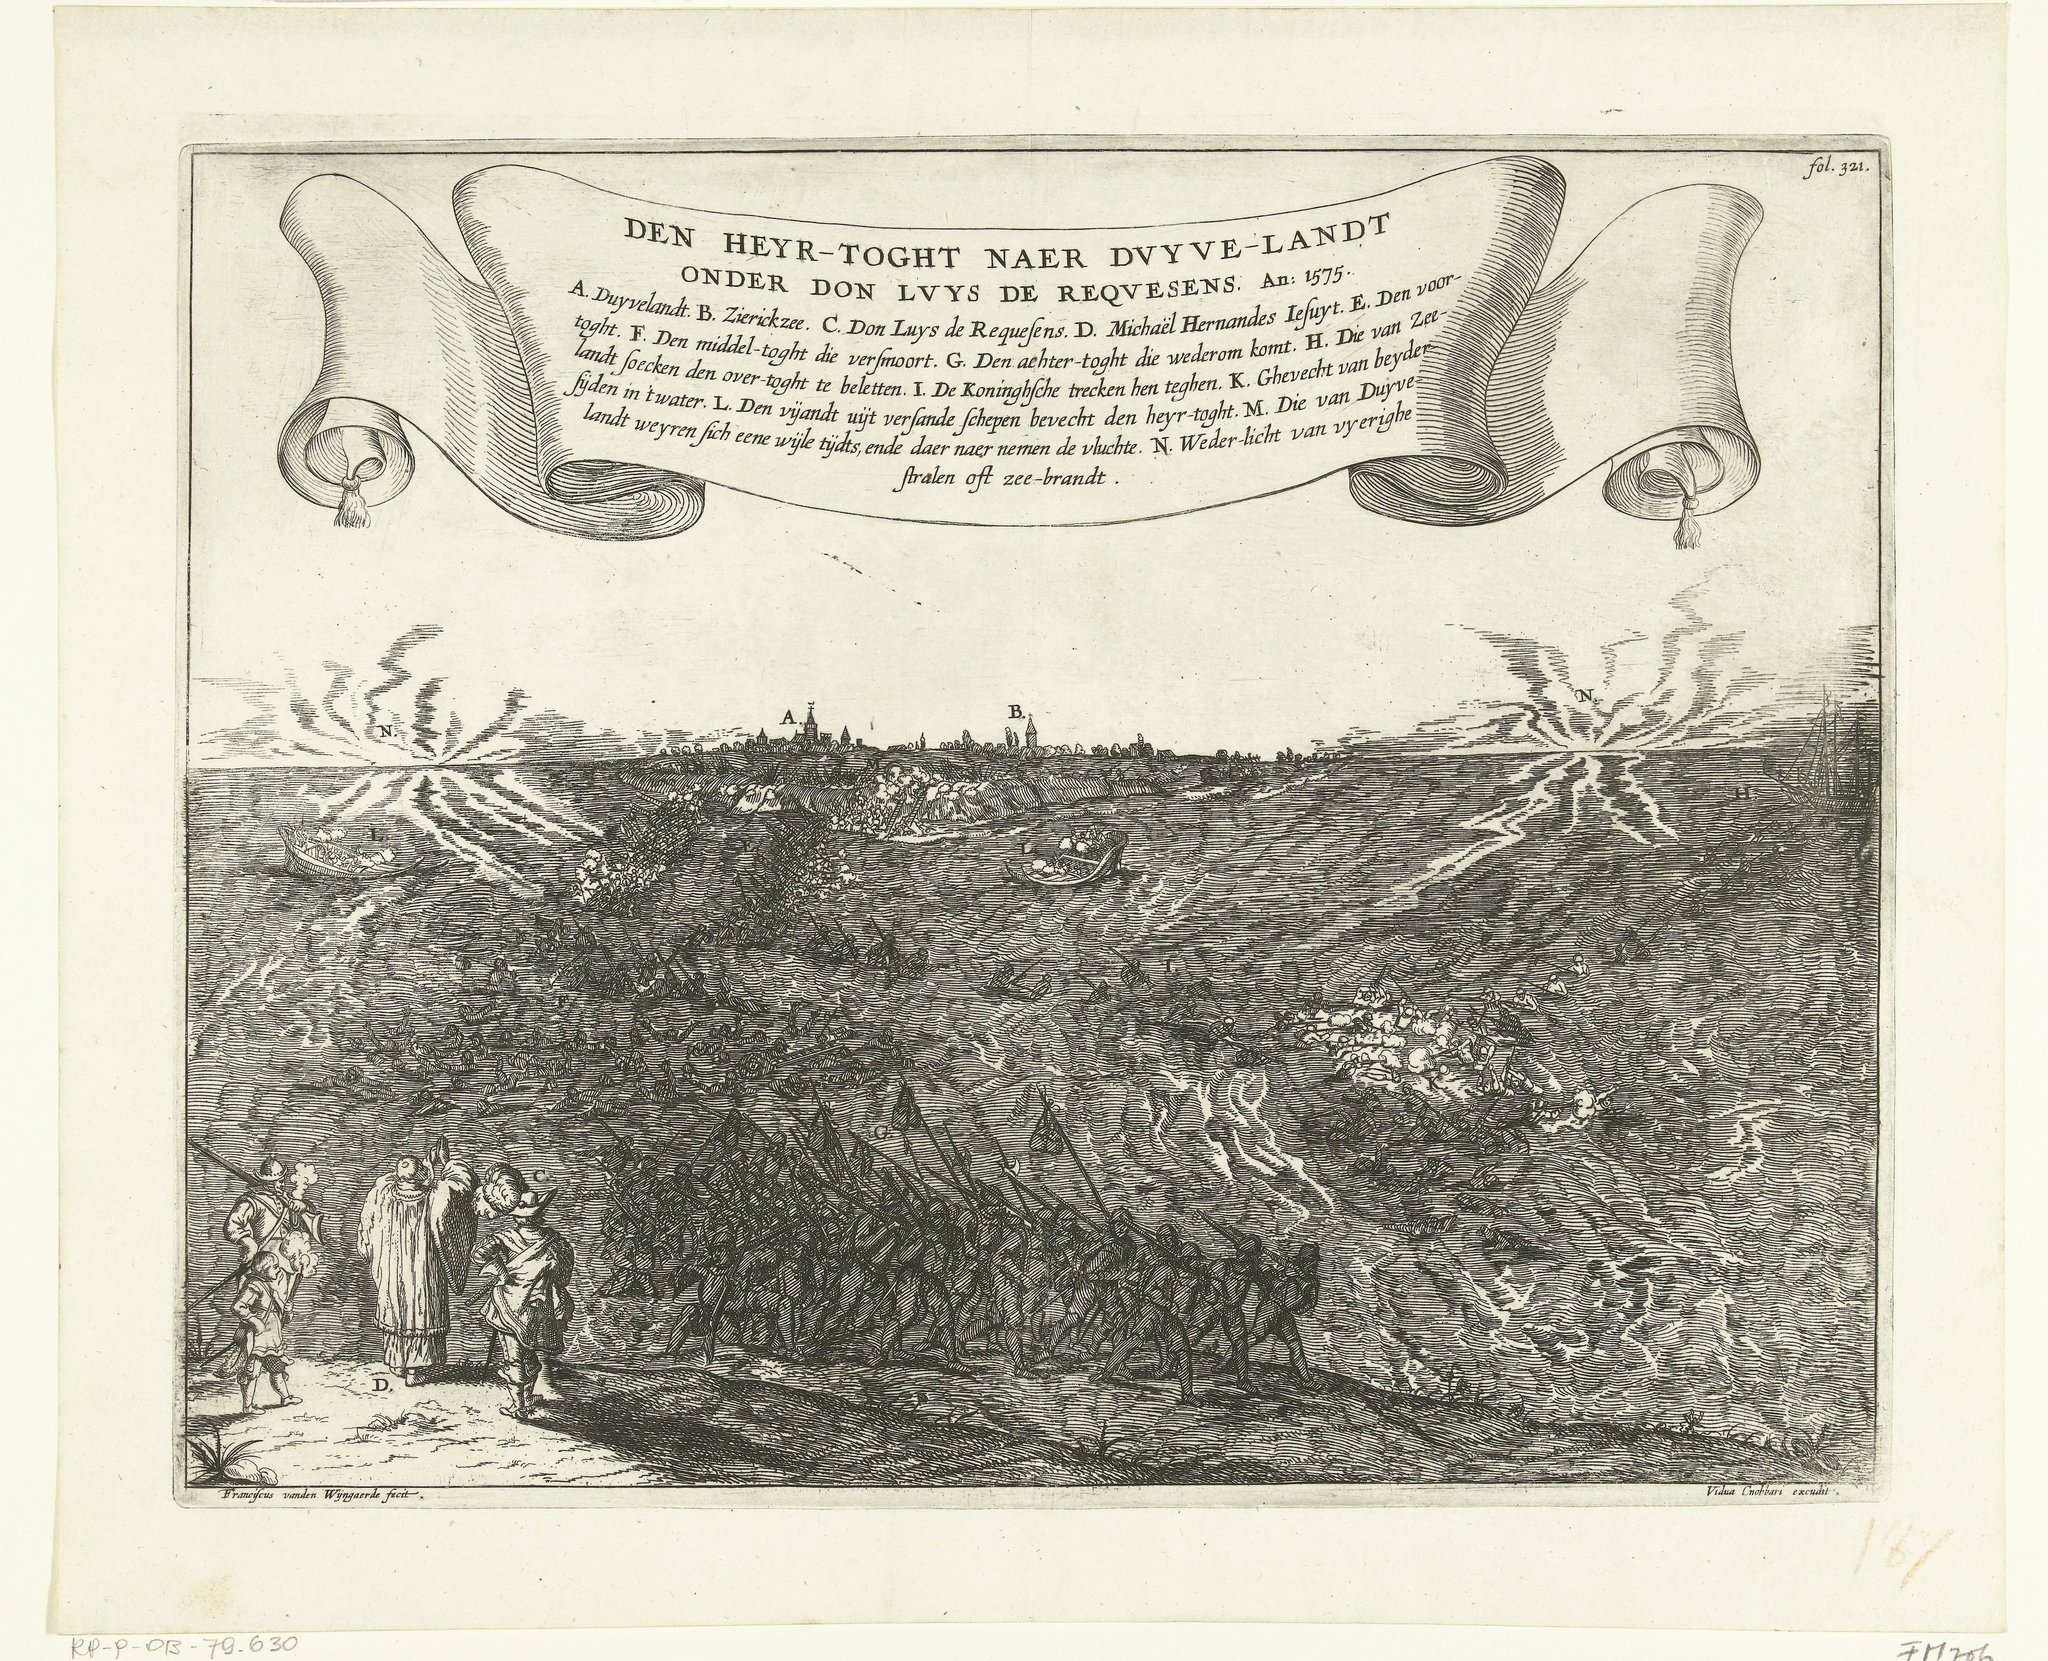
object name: print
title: Den heyr-toght naer Duyve-landt onder Don Luys de Requesens. An. 1575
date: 1643-1645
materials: paper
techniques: etching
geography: southern netherlands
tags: brussels, mayor, luis de zúñiga y requesens, army 'en route'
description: Nachtelijk tocht van Spaanse soldaten van Sint-Philipsland door het water naar het eiland Duiveland, 28 september 1575. Op de voorgrond op Tholen zegent een jezuïet de vertrekkende soldaten, in de verte het eiland Duivenland en Zierikzee. Bovenin een banderol met de titel en legenda A-N in het Nederlands.